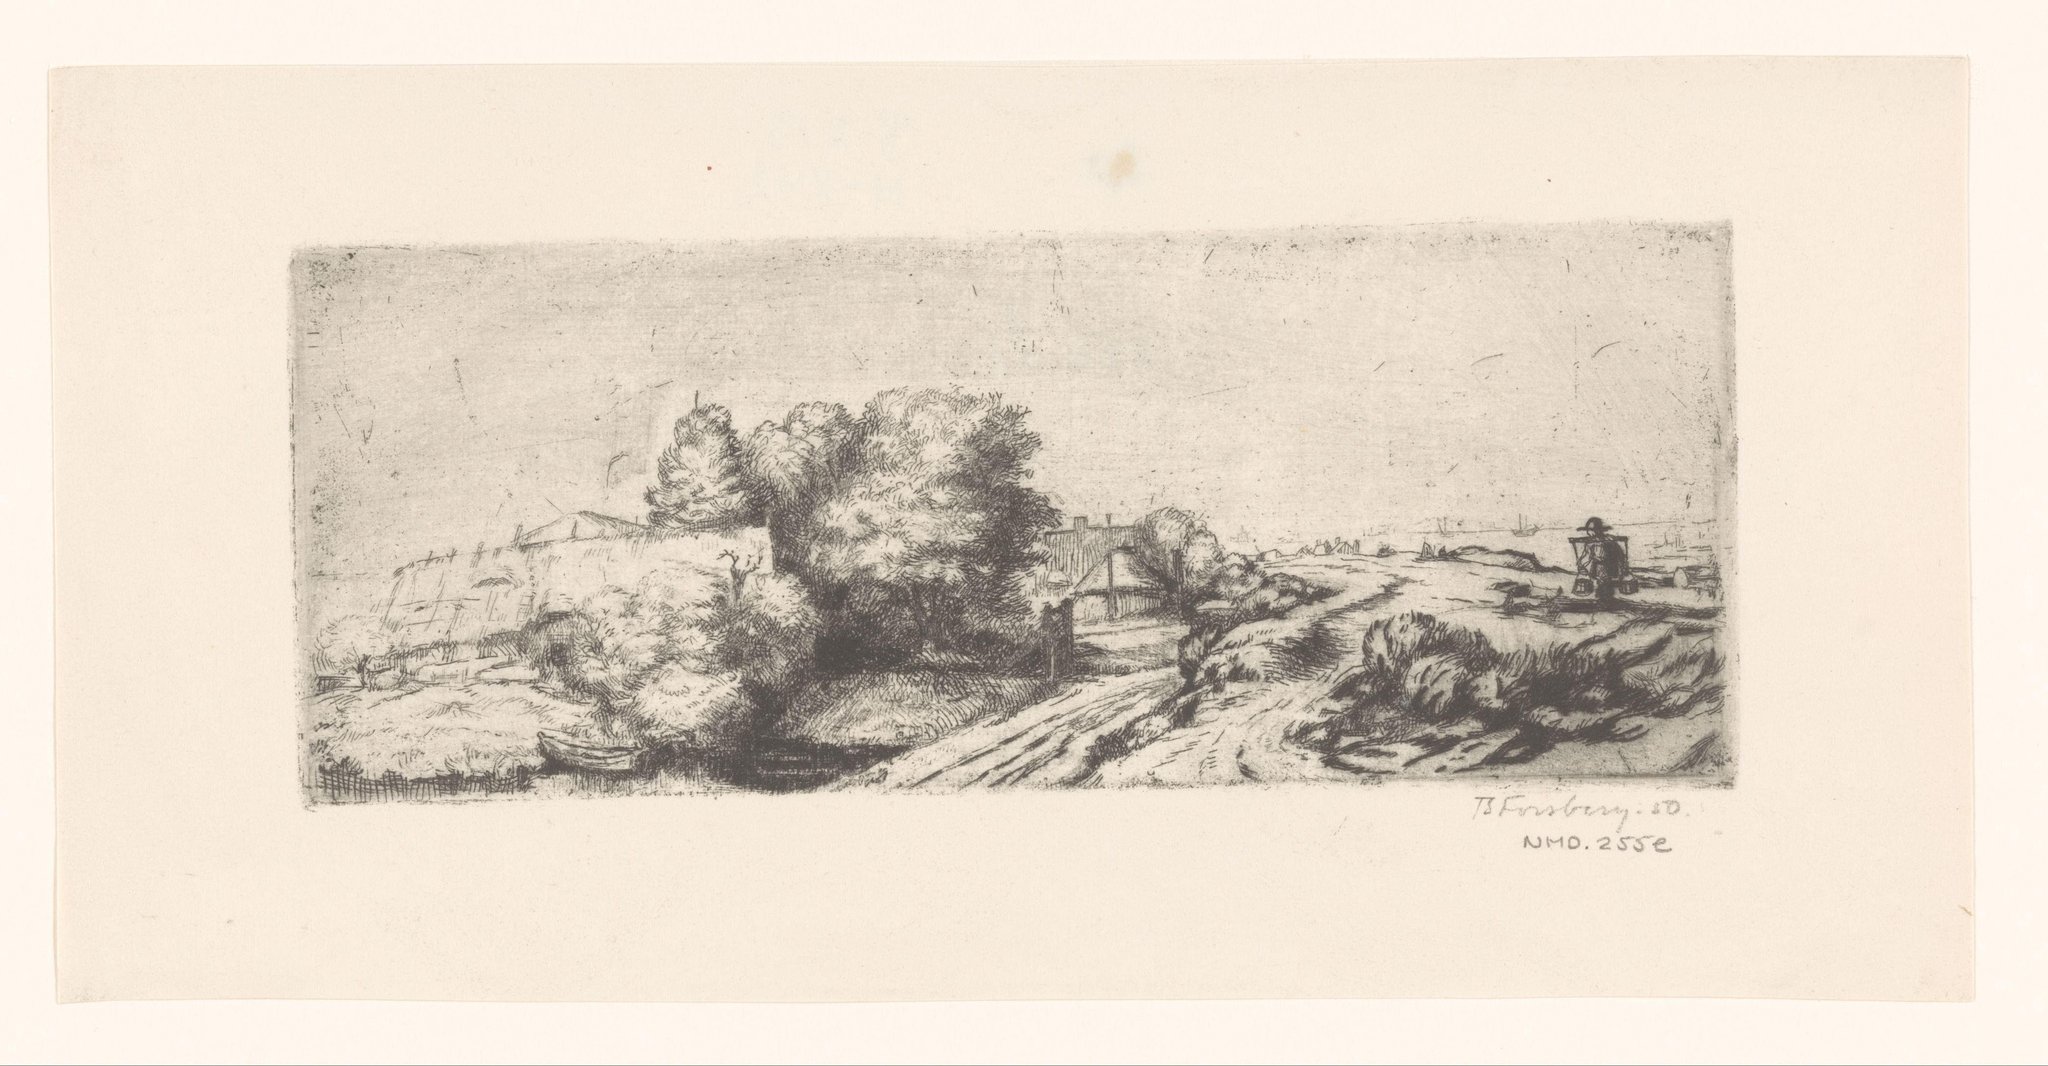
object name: print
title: View of the Diemerdijk with a milkman and cottages ('Het melkboertje')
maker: birger john forsberg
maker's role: print maker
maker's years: 1922-2012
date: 1932-1957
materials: paper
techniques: etching, intaglio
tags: city-view, and landscape with man-made constructions, transportation of milk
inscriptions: signature: ‘B. Forsberg -50’, collector's mark: Lugt 2760, collector's mark: Lugt 2228